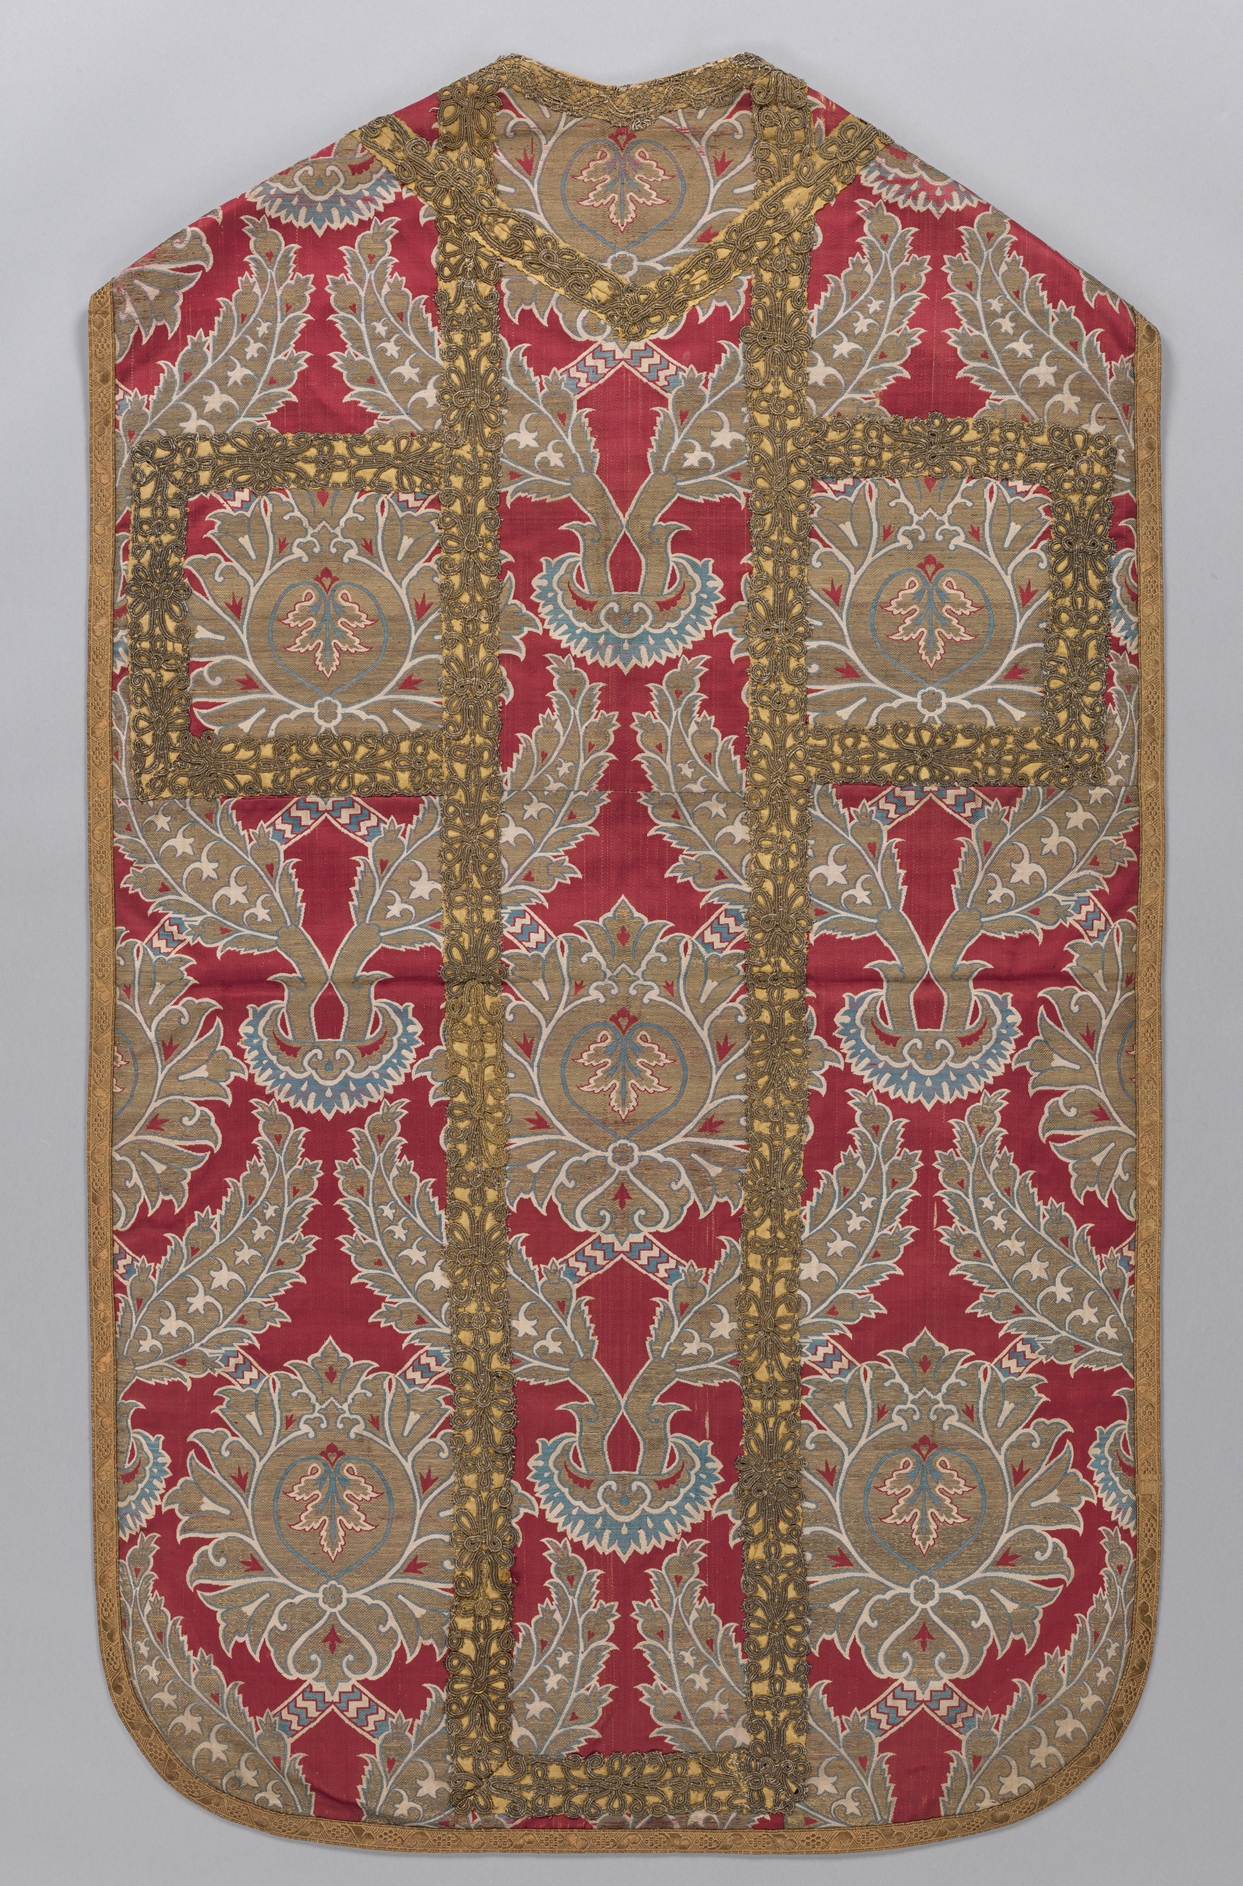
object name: chasuble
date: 1601-1700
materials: metal thread, silk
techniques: lampas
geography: turkey